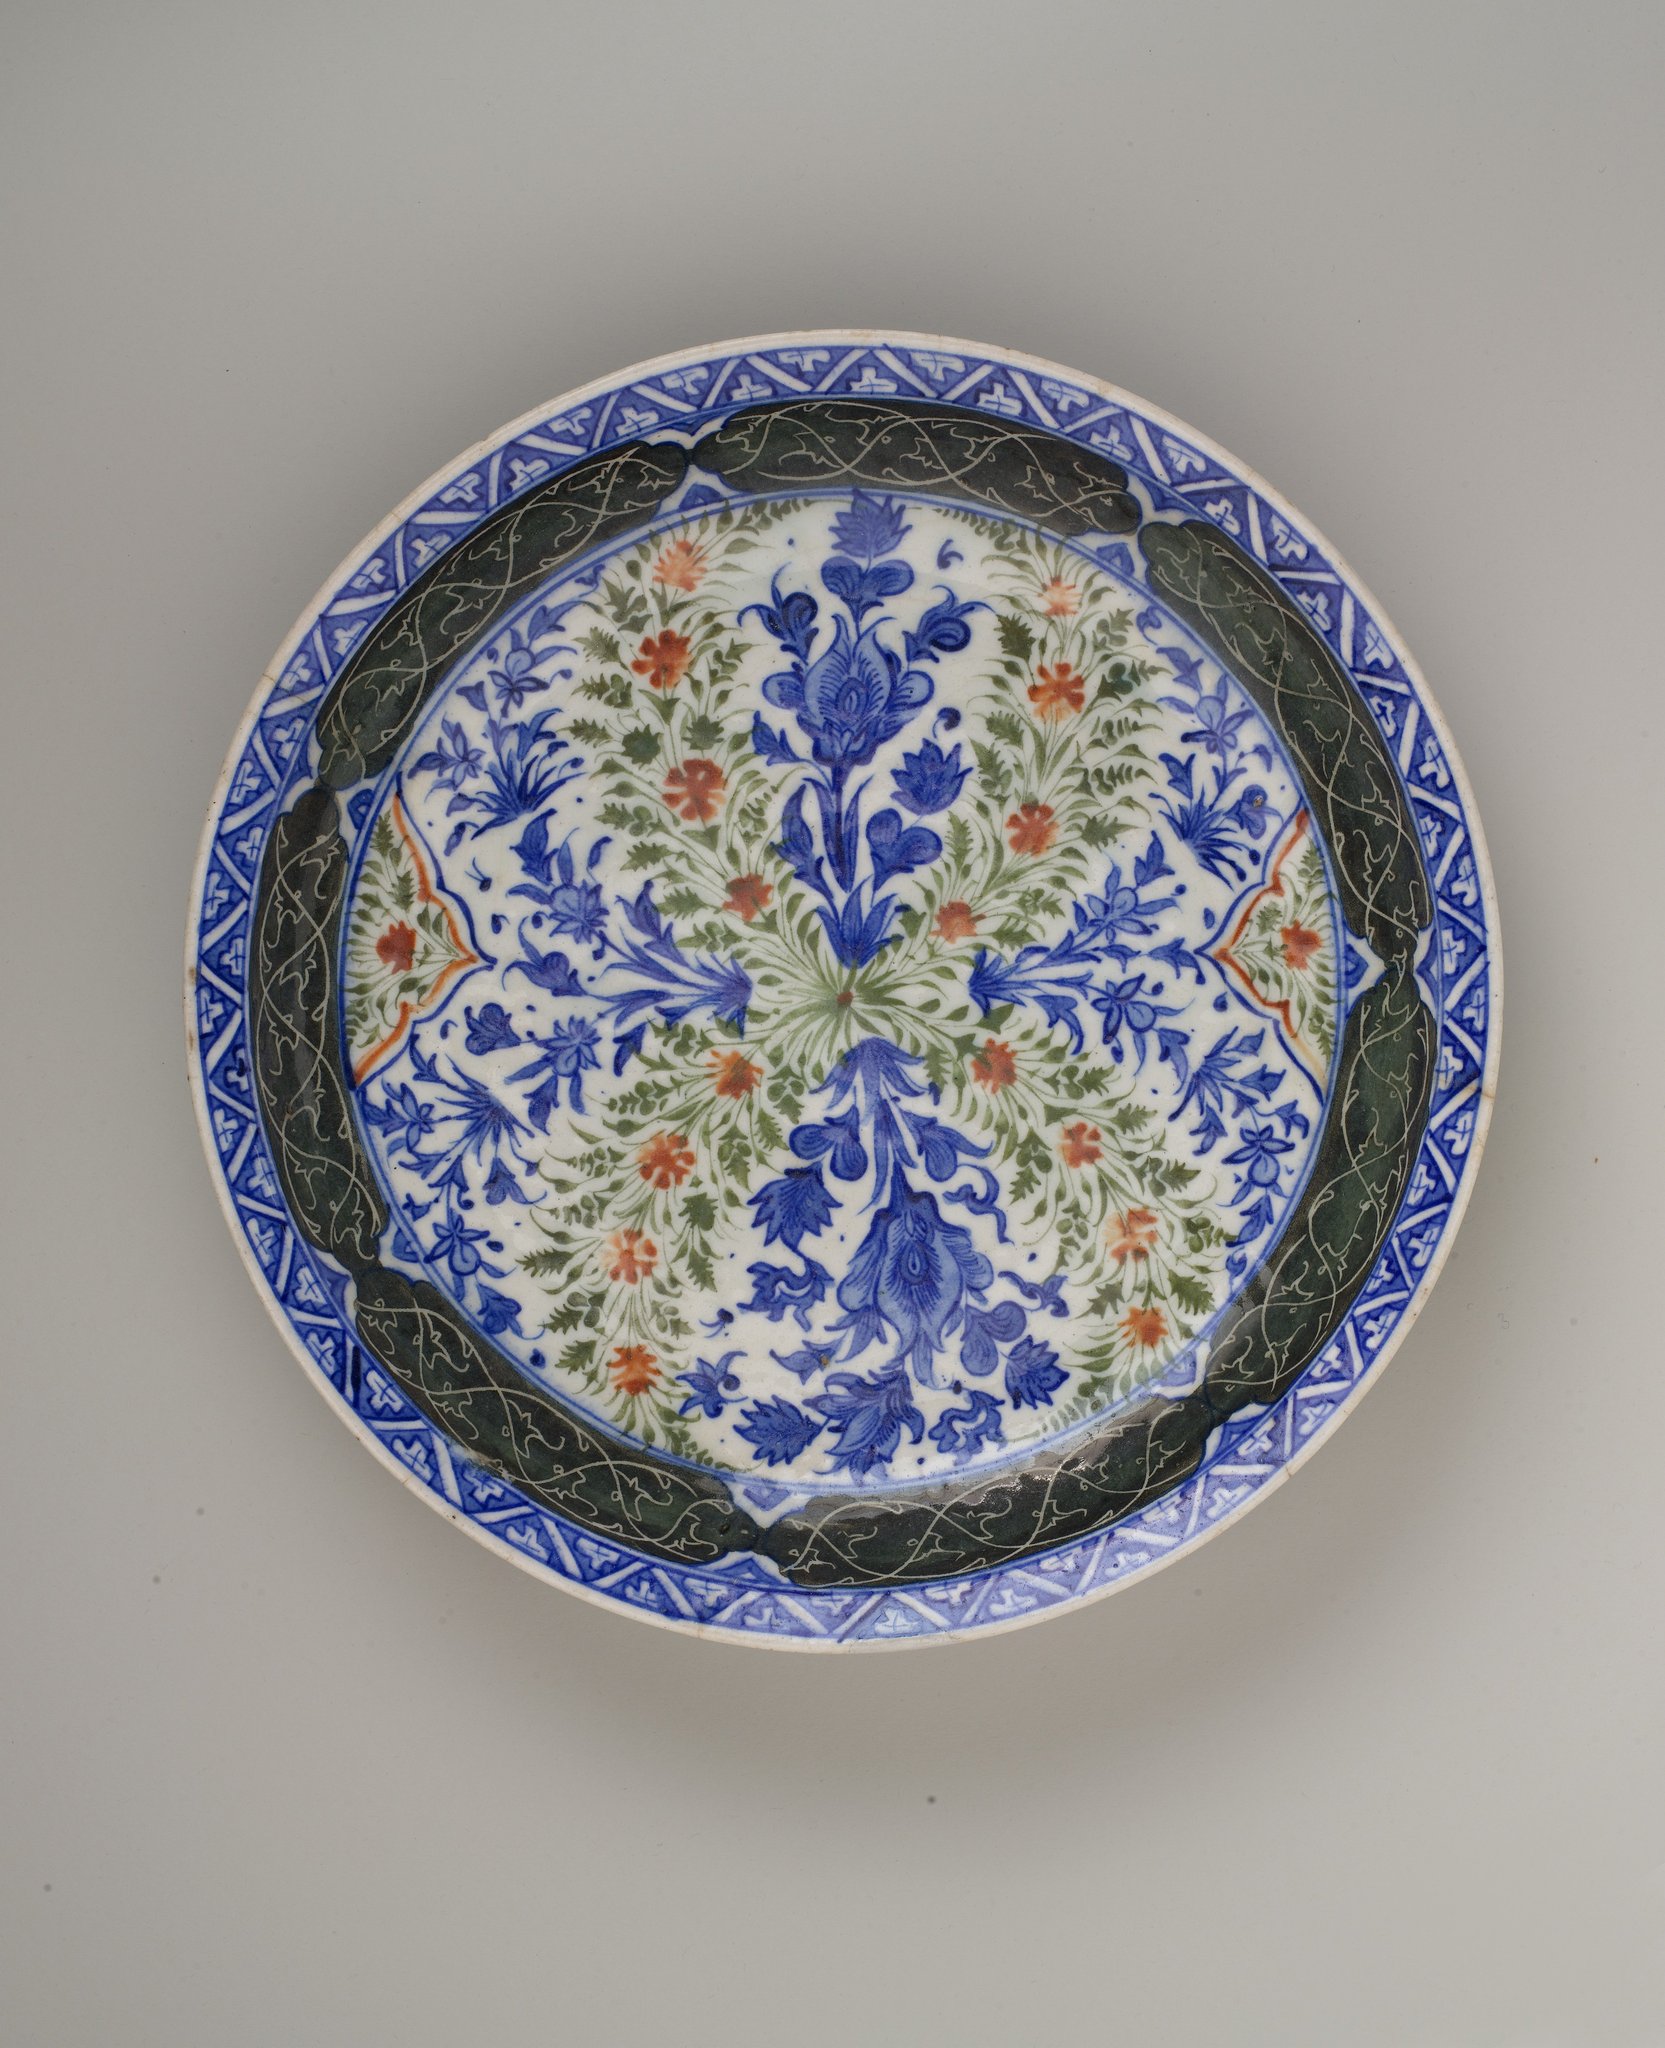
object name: dish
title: Dish with Floral Designs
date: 1670-1679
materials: glaze, stonepaste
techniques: painting, polychrome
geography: iran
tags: flowers,leaves